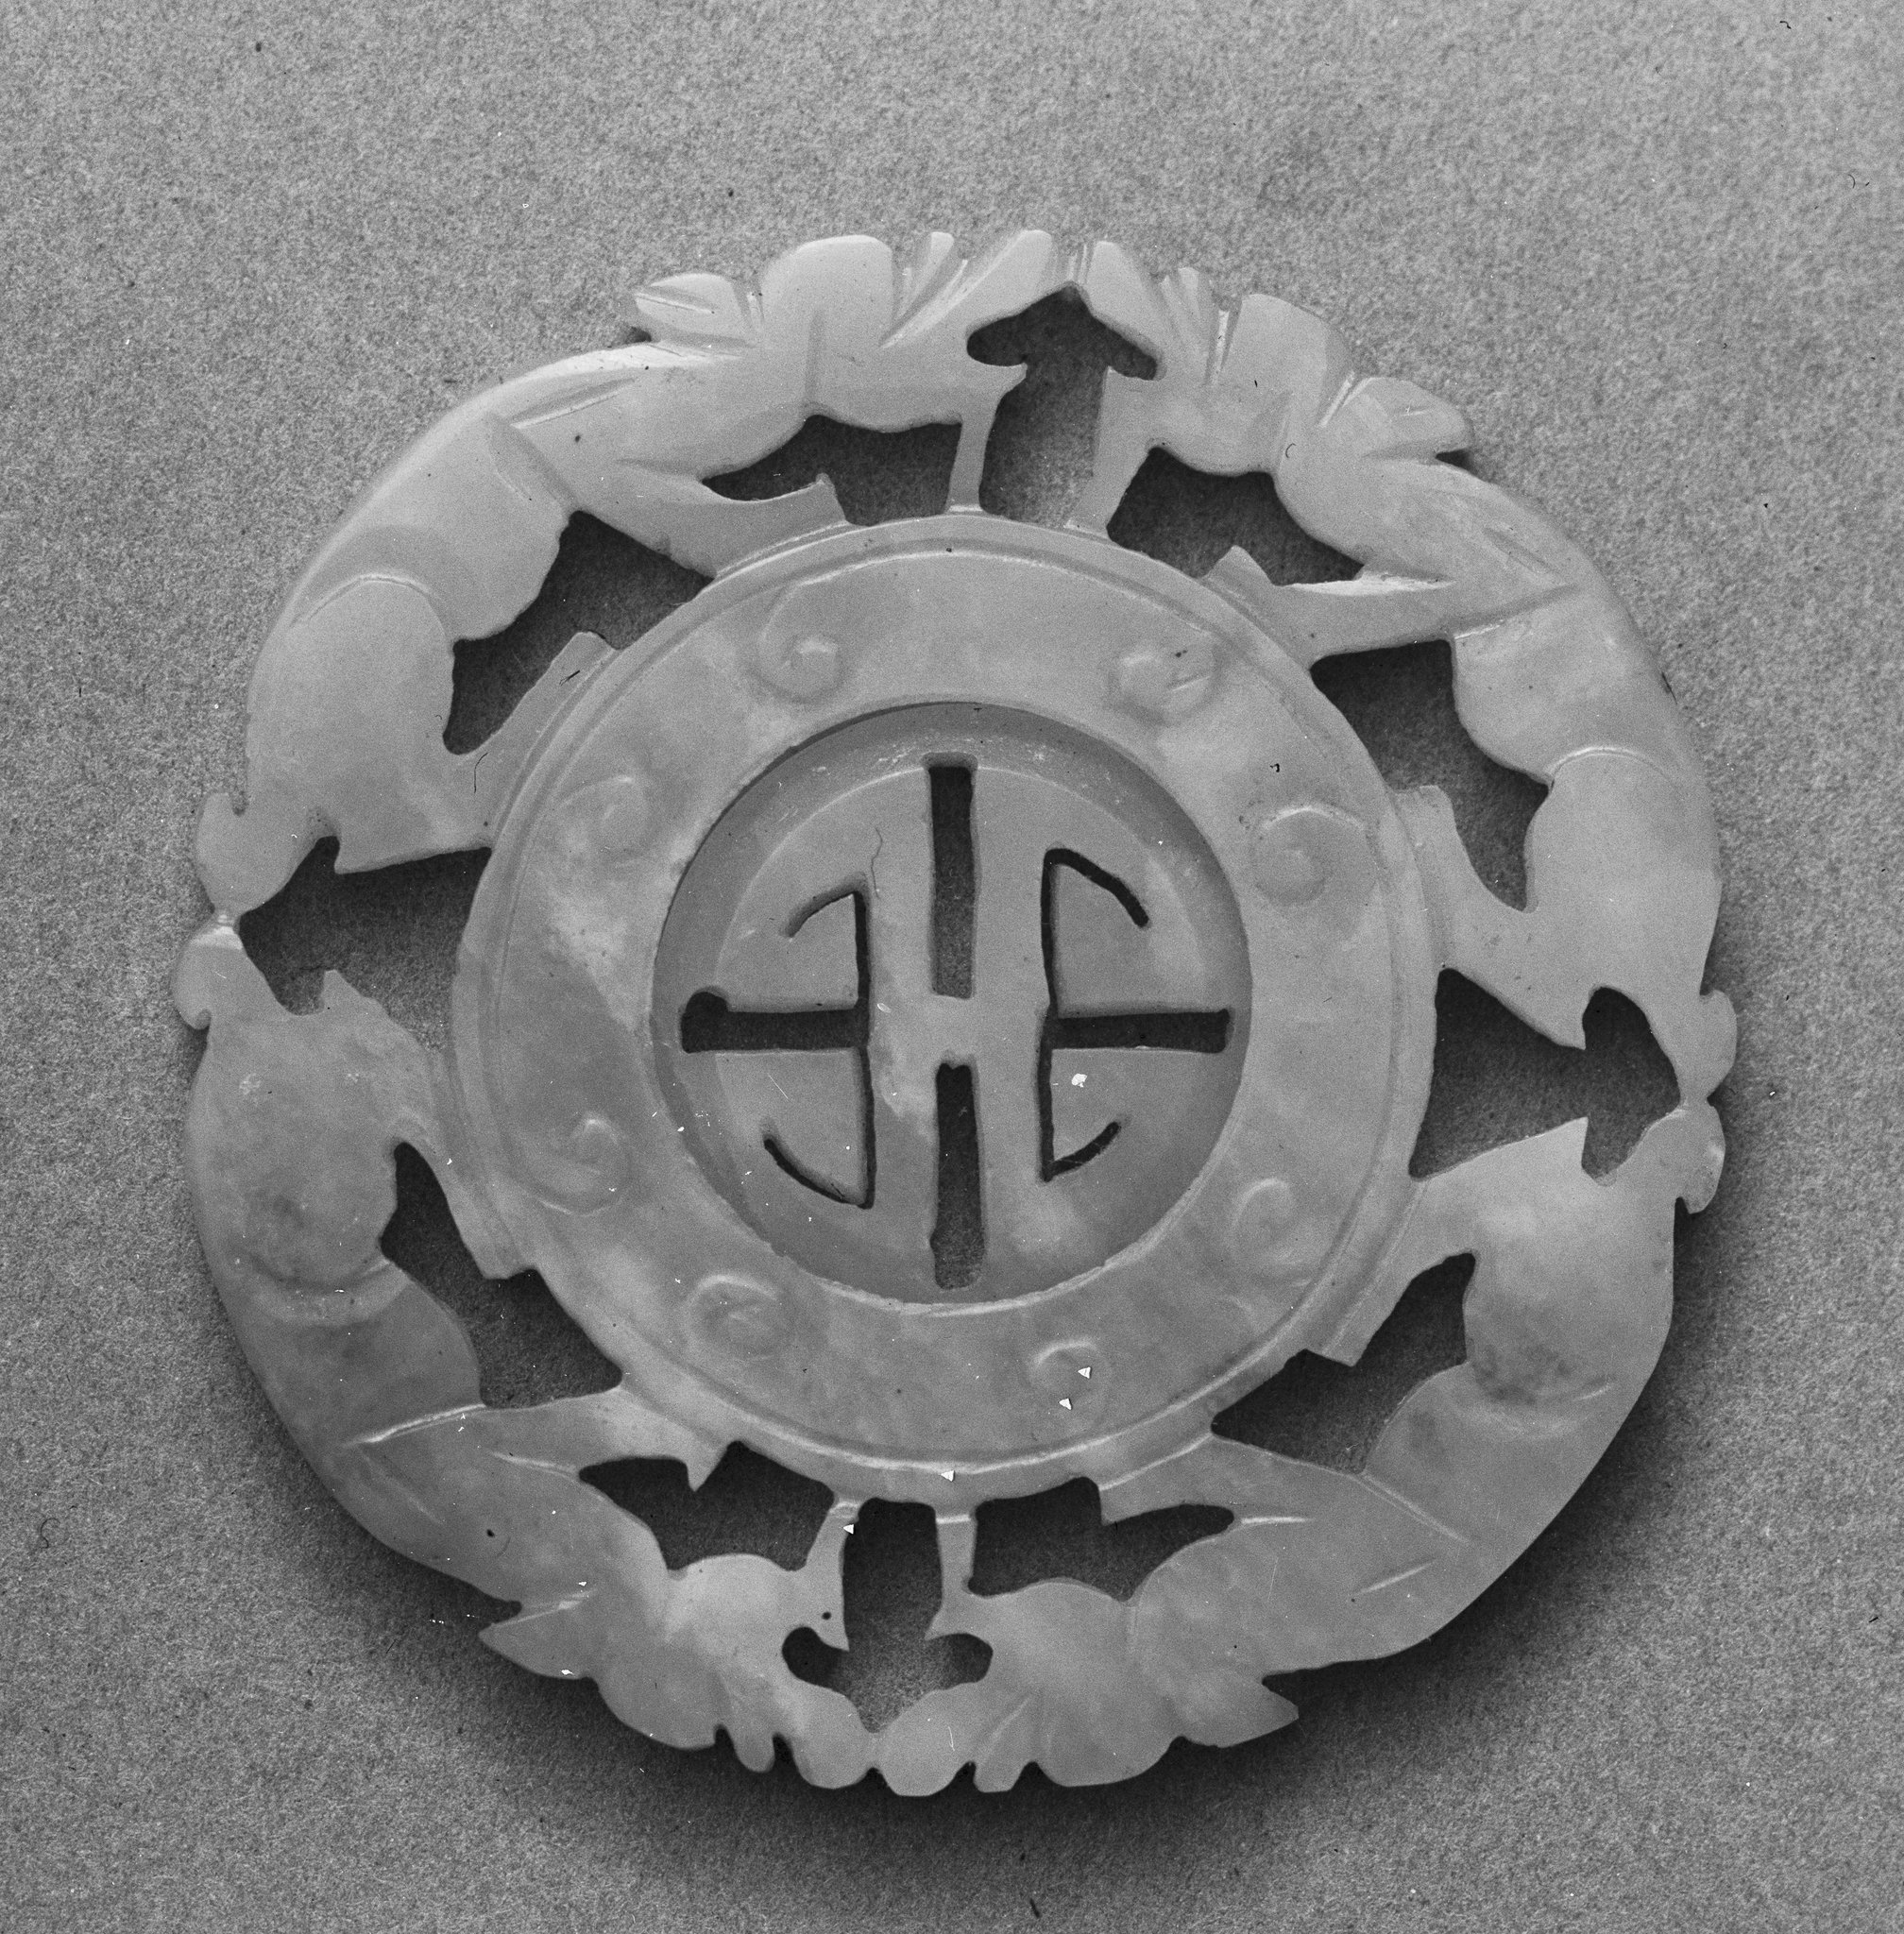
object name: disk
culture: chinese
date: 1801-1900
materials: jade